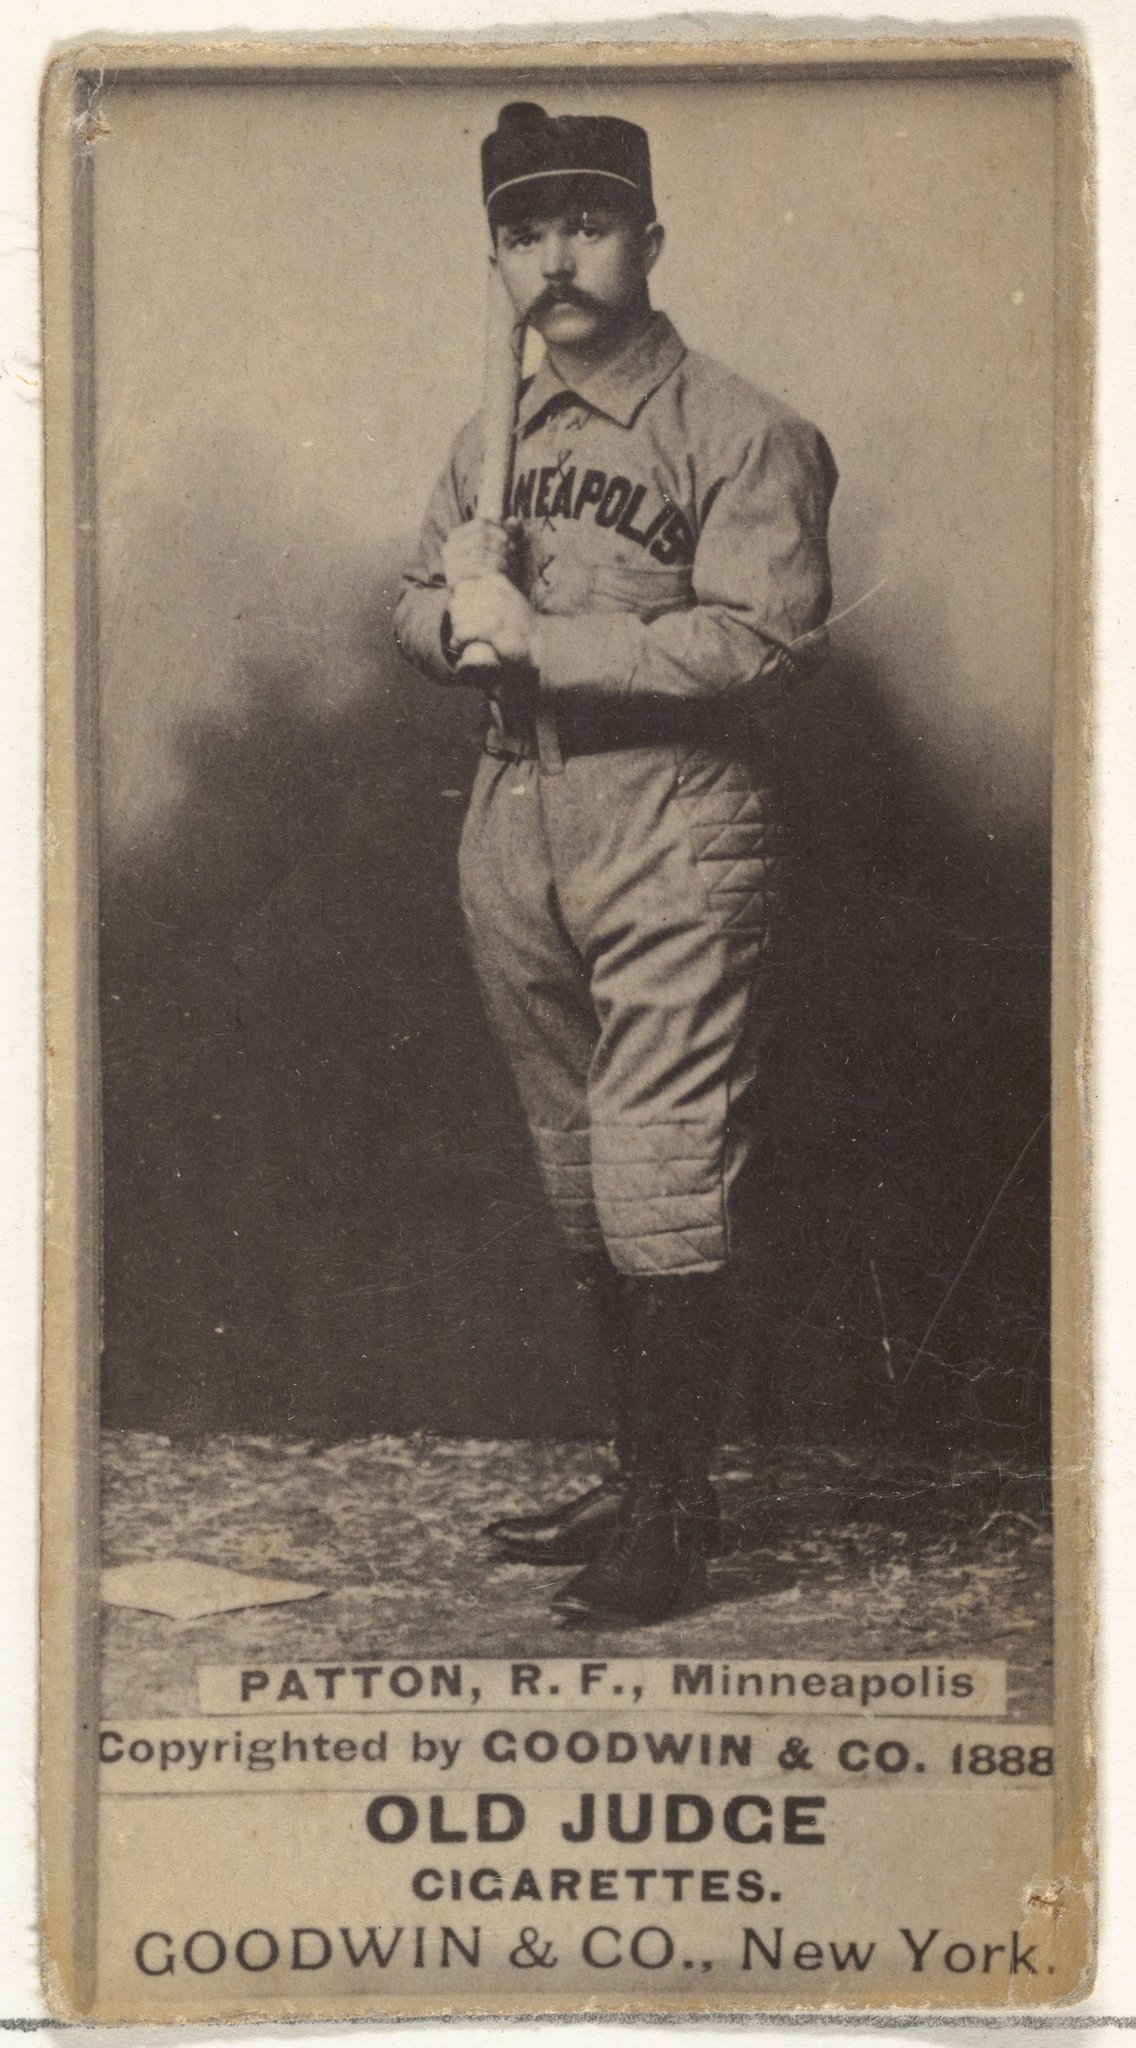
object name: baseball card, photograph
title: Owen Joseph Patton, Right Field, Minneapolis, from the Old Judge series (N172) for Old Judge Cigarettes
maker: goodwin & company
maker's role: publisher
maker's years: 1850-1950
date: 1888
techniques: albumen silver print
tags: men,portraits,baseball,athletes